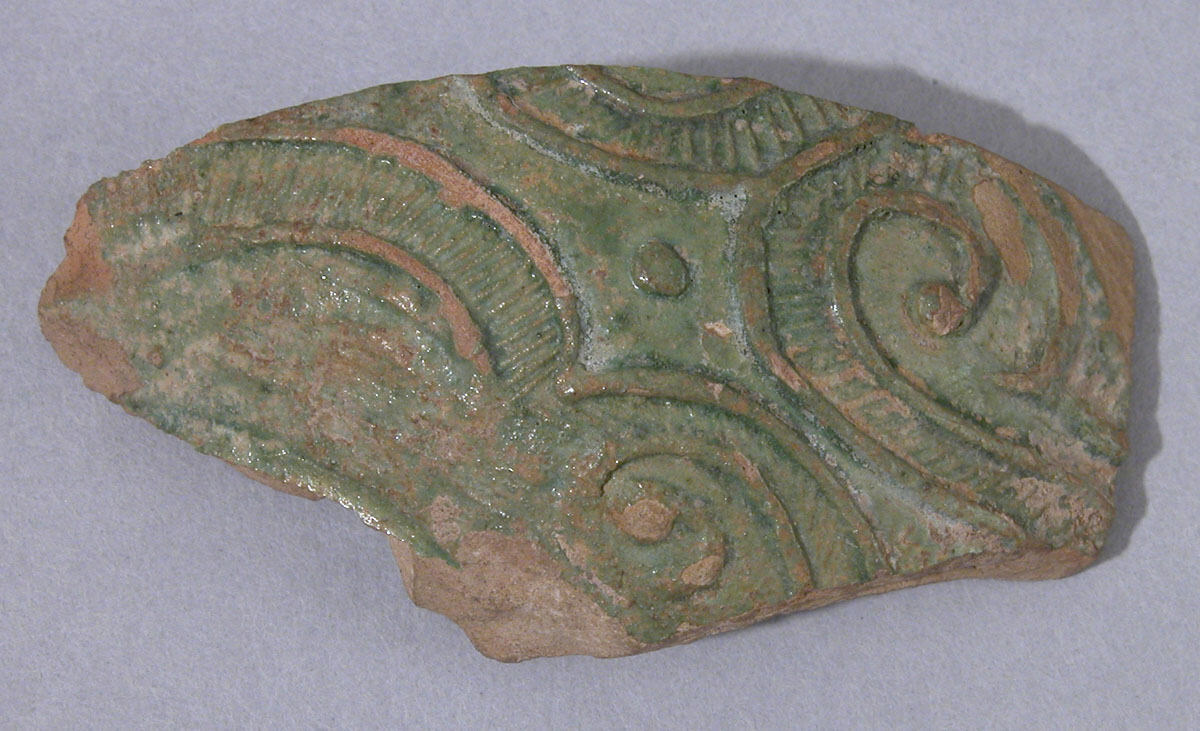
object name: fragment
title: Ceramic Fragment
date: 801-1000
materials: earthenware, glaze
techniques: molding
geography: iran